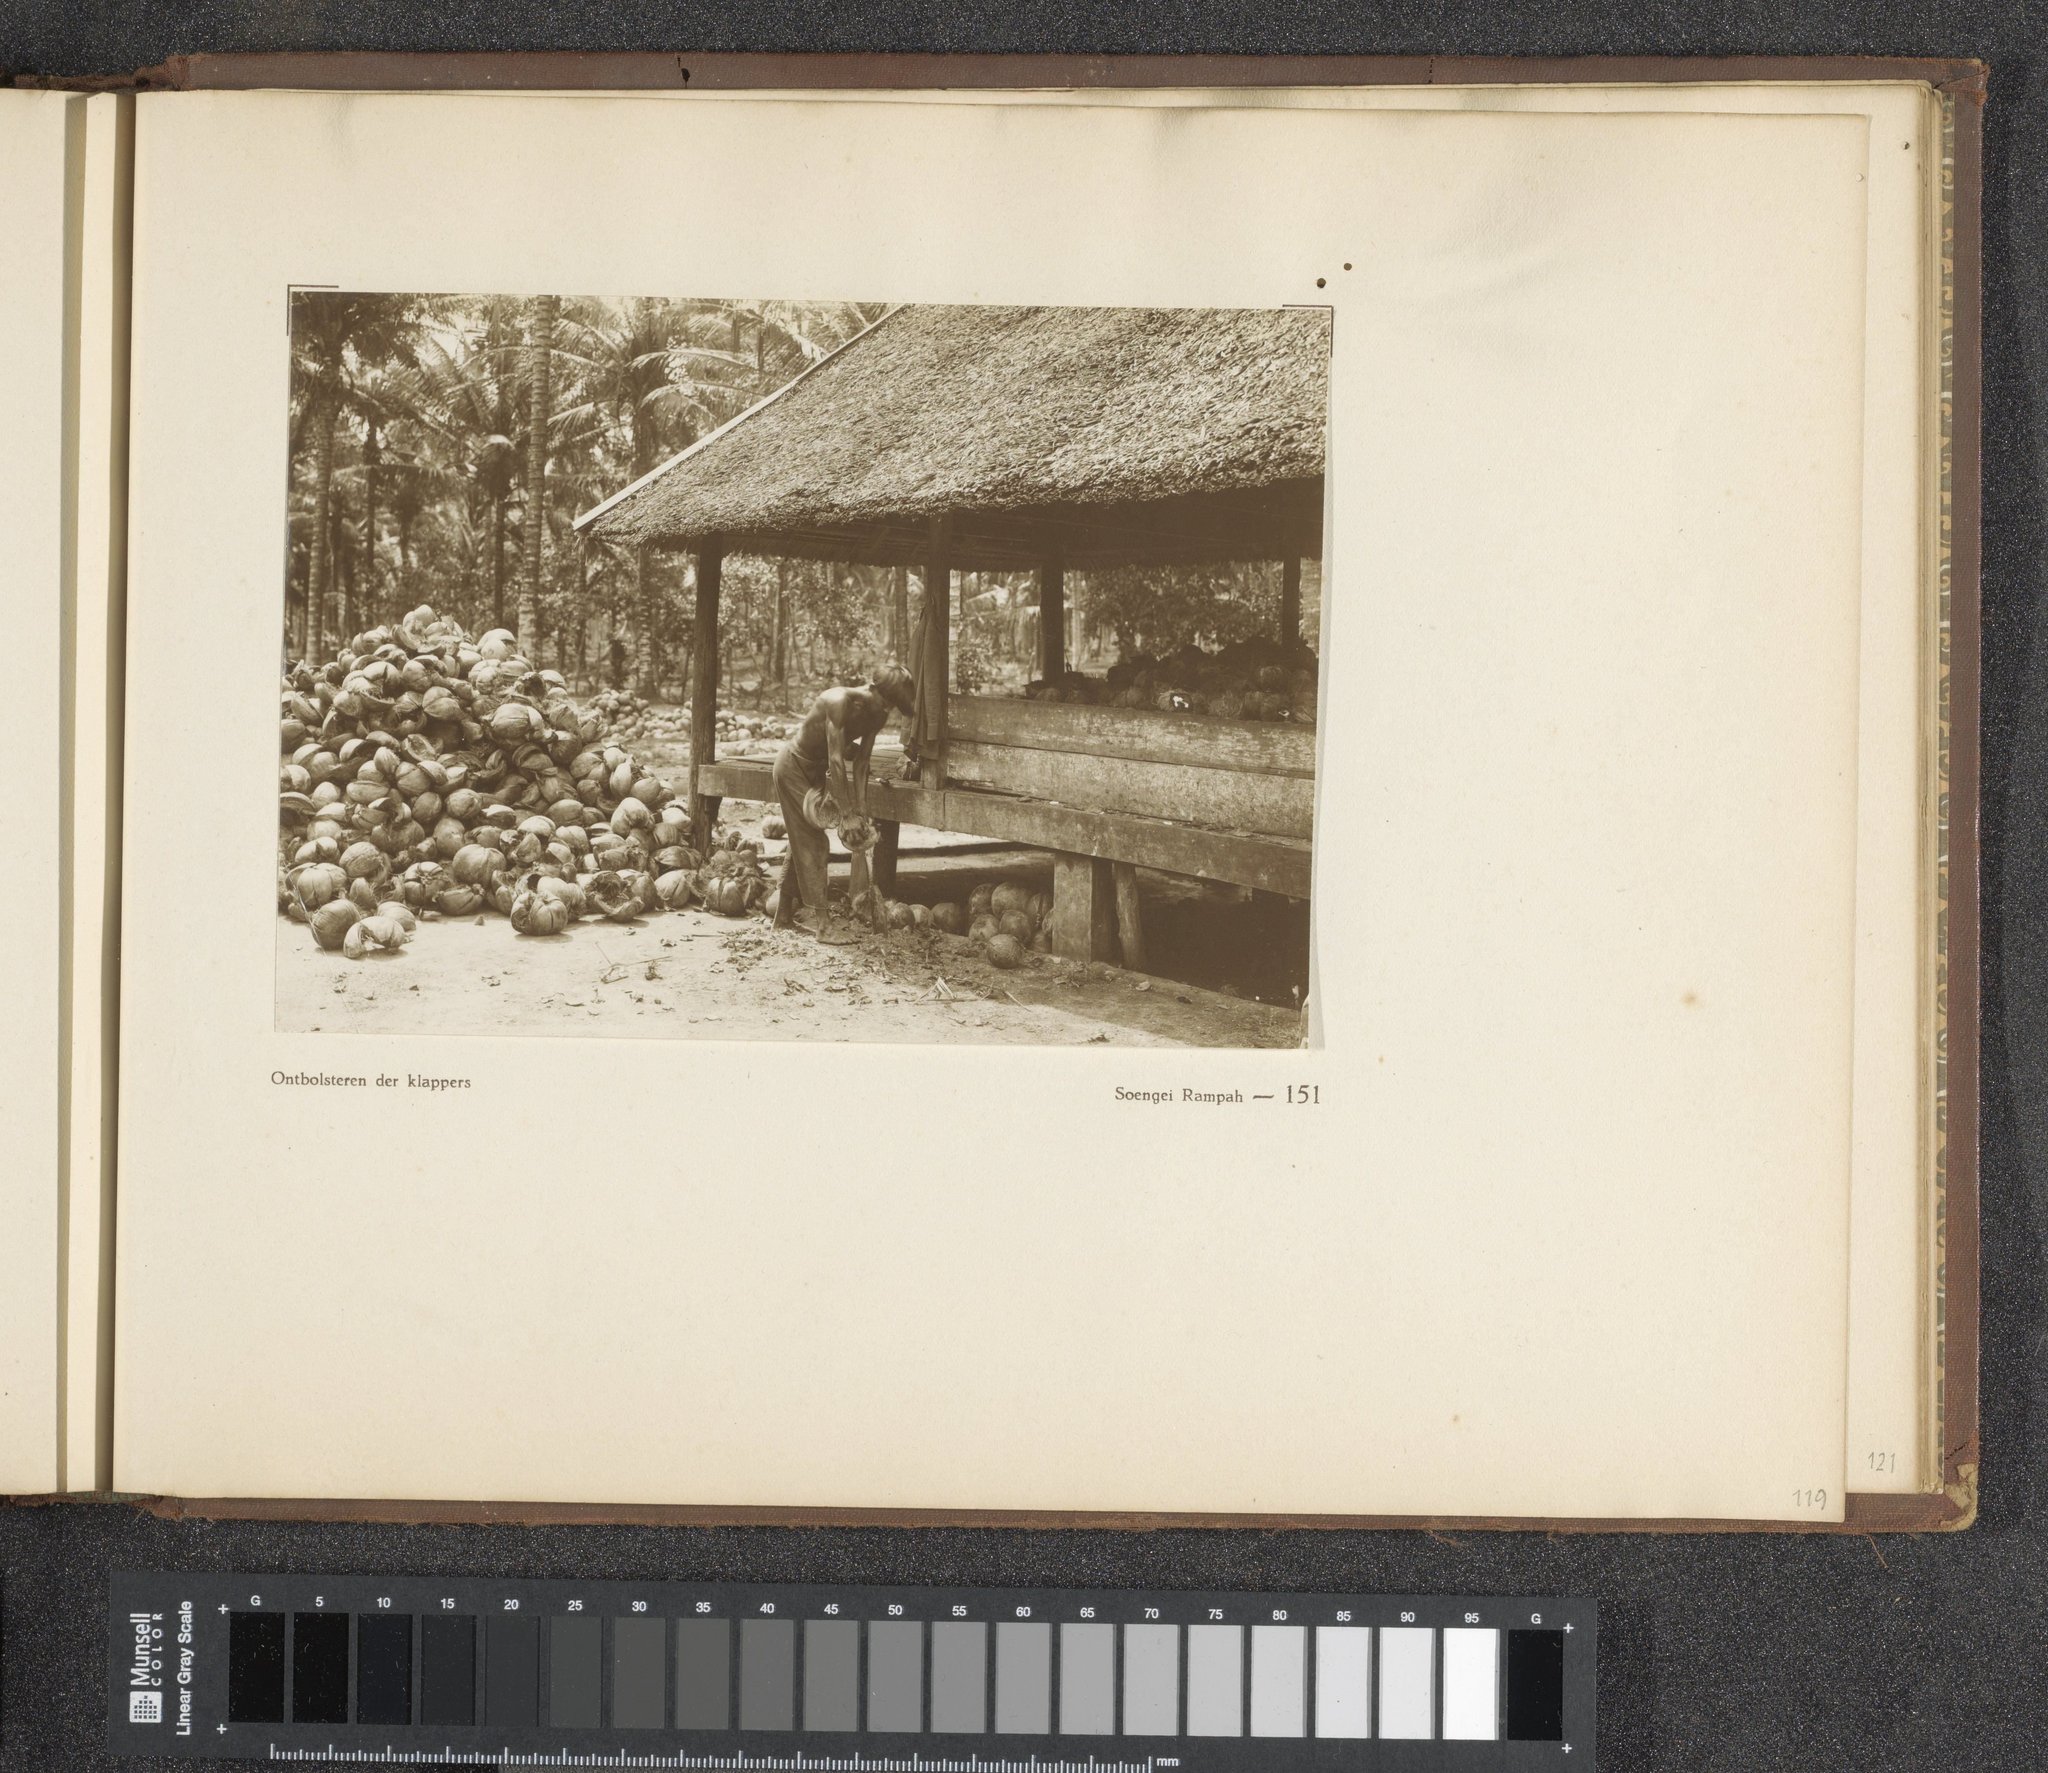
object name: photograph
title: Pagina 151 van fotoboek van de Algemeene Vereeniging van Rubberplanters ter Oostkust van Sumatra (A.V.R.O.S.)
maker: j.w. meyster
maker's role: fotograaf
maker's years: 1887-1945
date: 1924-1925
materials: paper, photographic support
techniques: printing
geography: sumatra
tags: harvest, plantation, (non-fruit) products of plants or trees: rubber, trees: coconut-tree, sumatra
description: Boekpagina met een foto van een Indische man die kokosnoten ontbolstert op een plantage te Soengei Rampah. Onderdeel van een fotoboek van de Algemeene Vereeniging van Rubberplanters ter Oostkust van Sumatra (A.V.R.O.S.).